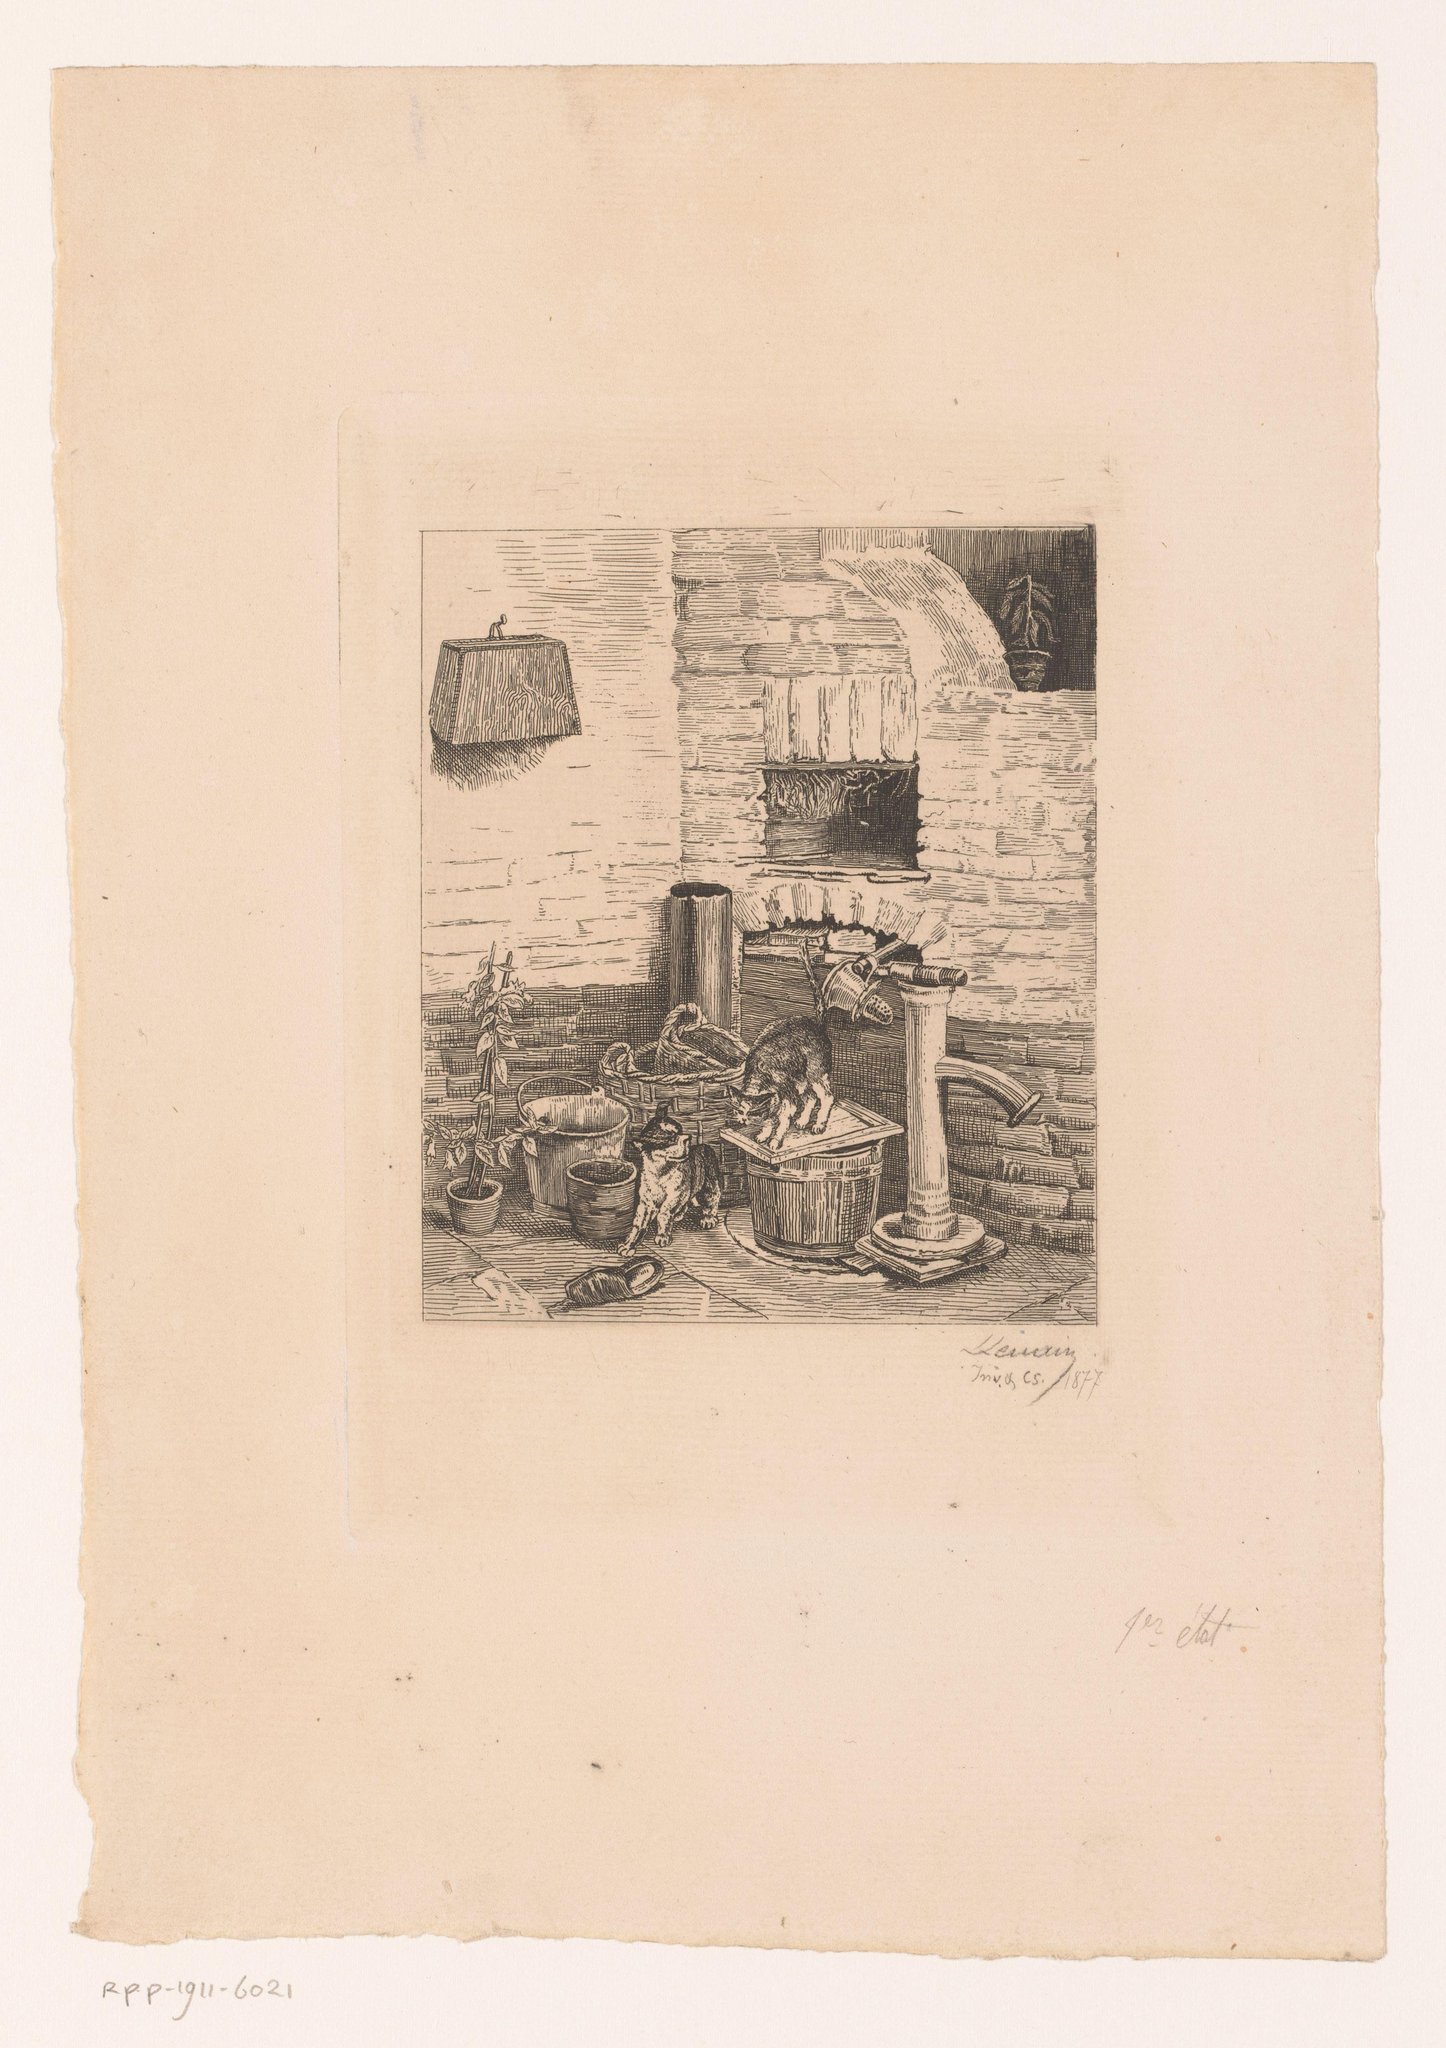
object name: print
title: Hond en kat bij een waterpomp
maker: louis le nain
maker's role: print maker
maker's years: 1851-1939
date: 1877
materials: paper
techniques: etching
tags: wooden container: barrel, cask, bucket, cat, pump, dog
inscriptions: collector's mark: Lugt 2228, inscription: ‘LLenain inv.&cs. / 1877, 1er état’